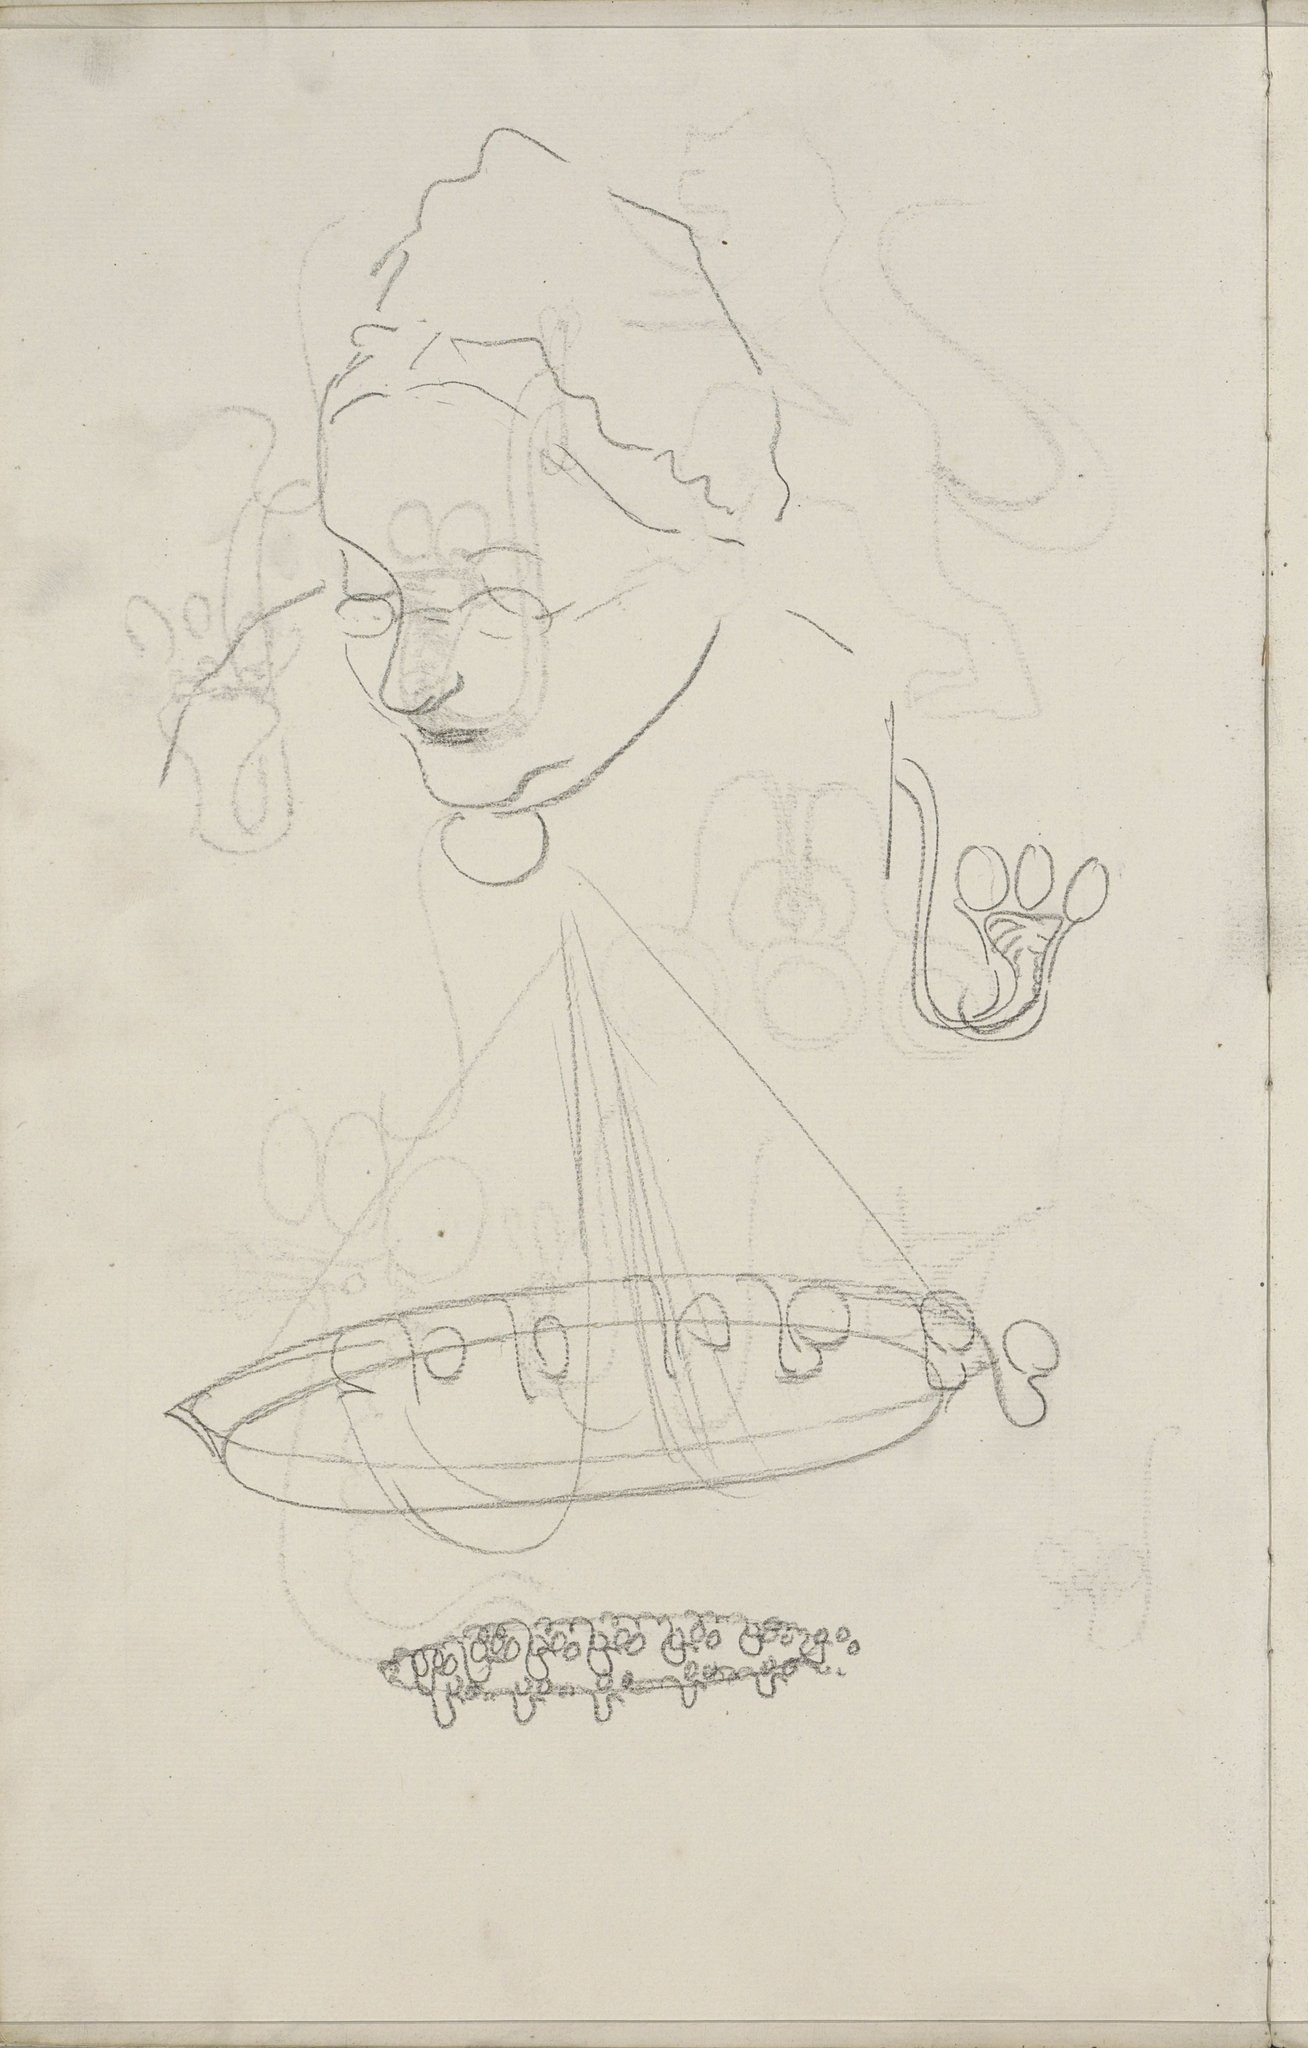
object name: sketchbook leaf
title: Portret van een vrouw en een kroonluchter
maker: carel adolph lion cachet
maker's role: draughtsman, print maker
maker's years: 1864-1945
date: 1895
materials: chalk, paper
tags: head (human), chandelier, candelabrum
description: Tevens studies van decoraties voor een kroonluchter. Blad 20 verso uit een schetsboek met 23 bladen.